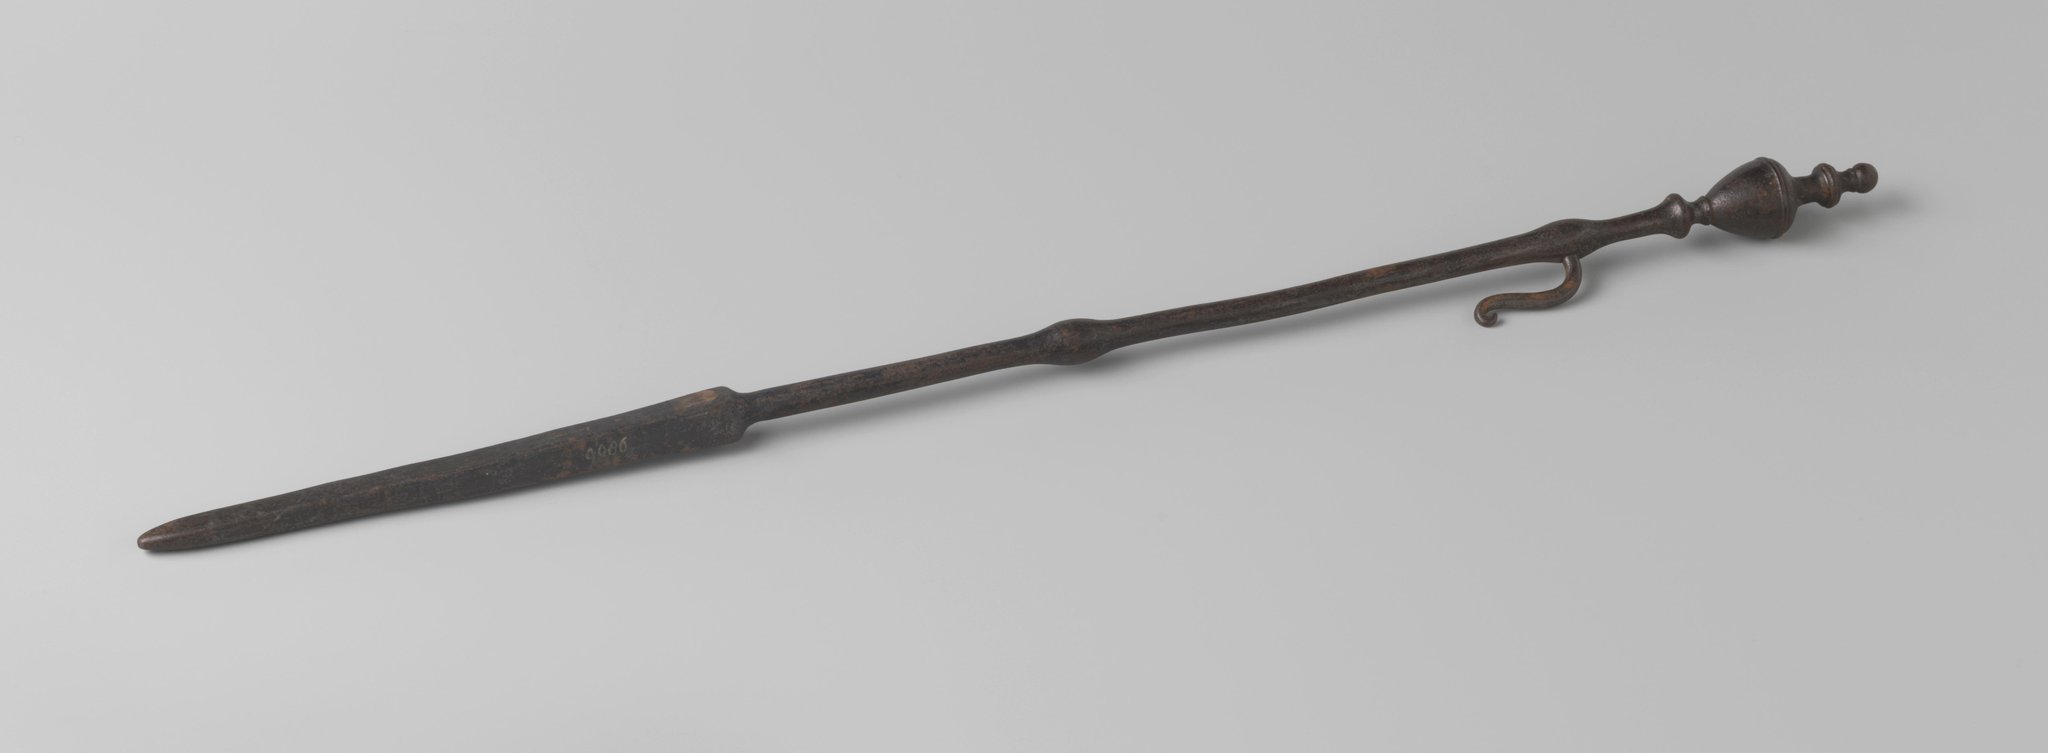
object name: poker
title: Pook van ijzer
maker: Anonymous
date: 1400-1950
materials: iron